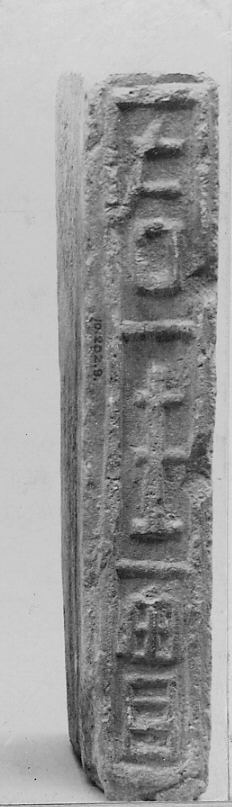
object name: tile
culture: chinese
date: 221 BCE-220 CE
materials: earthenware